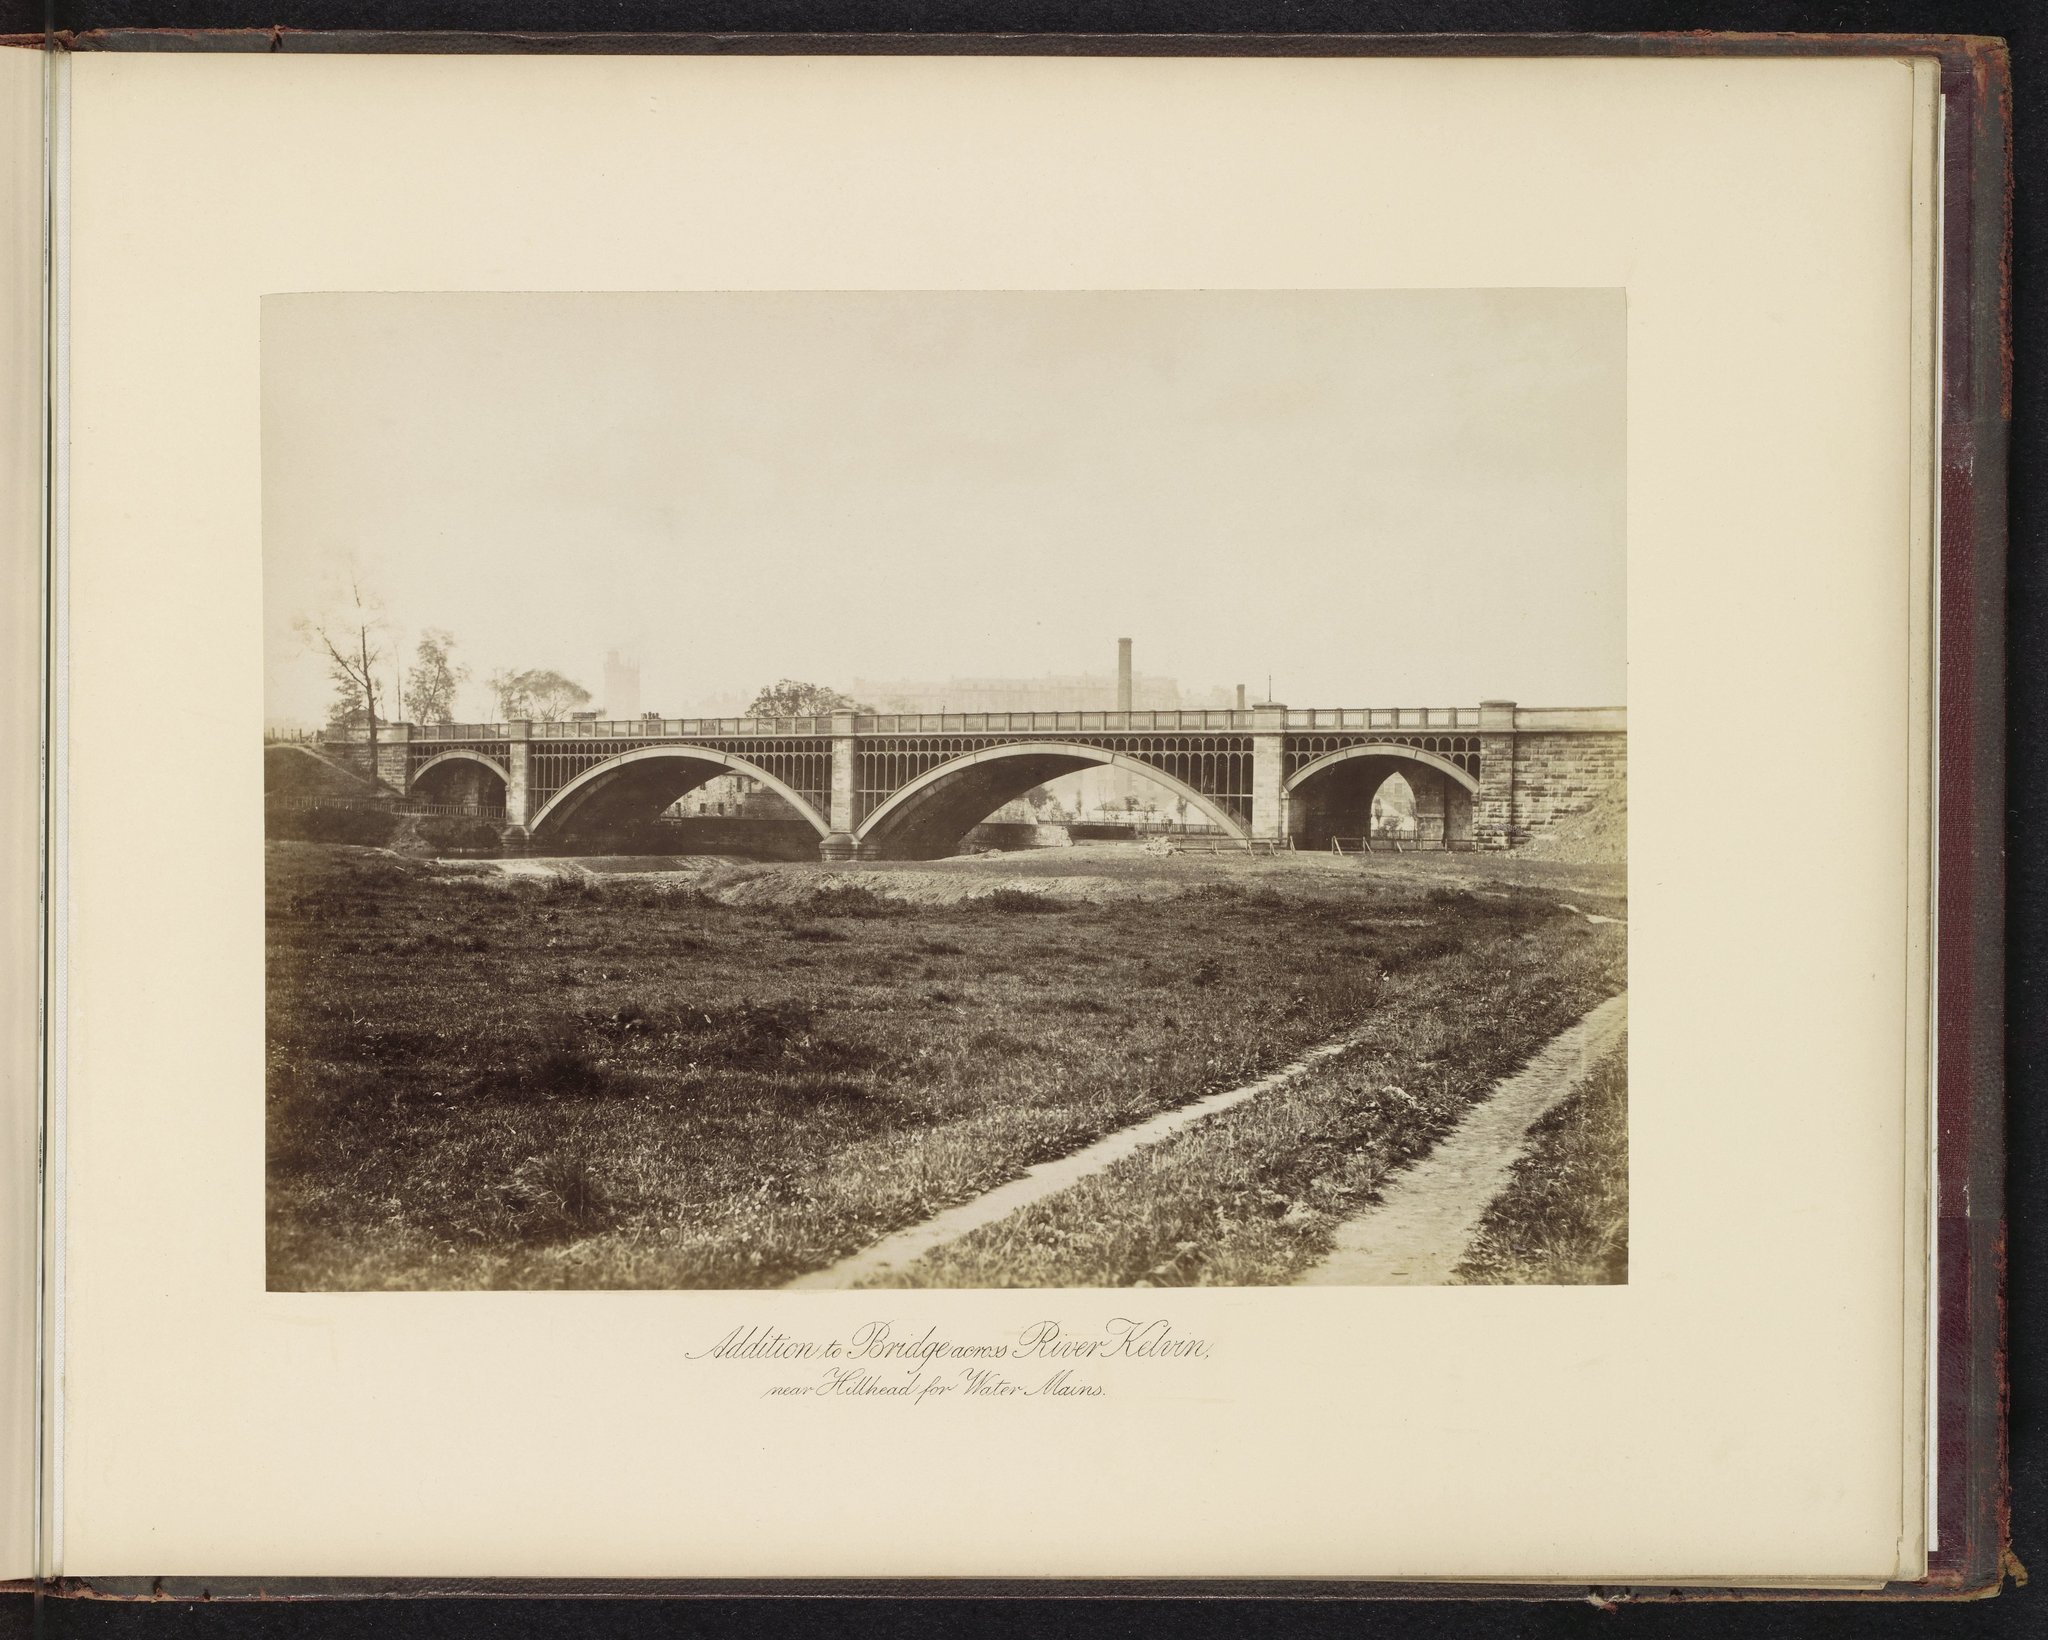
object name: page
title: Addition to Bridge across river Kelvin, near Hillhead for water mains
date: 1879-1889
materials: photographic support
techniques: albumen print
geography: scotland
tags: landscape with bridge, viaduct or aqueduct